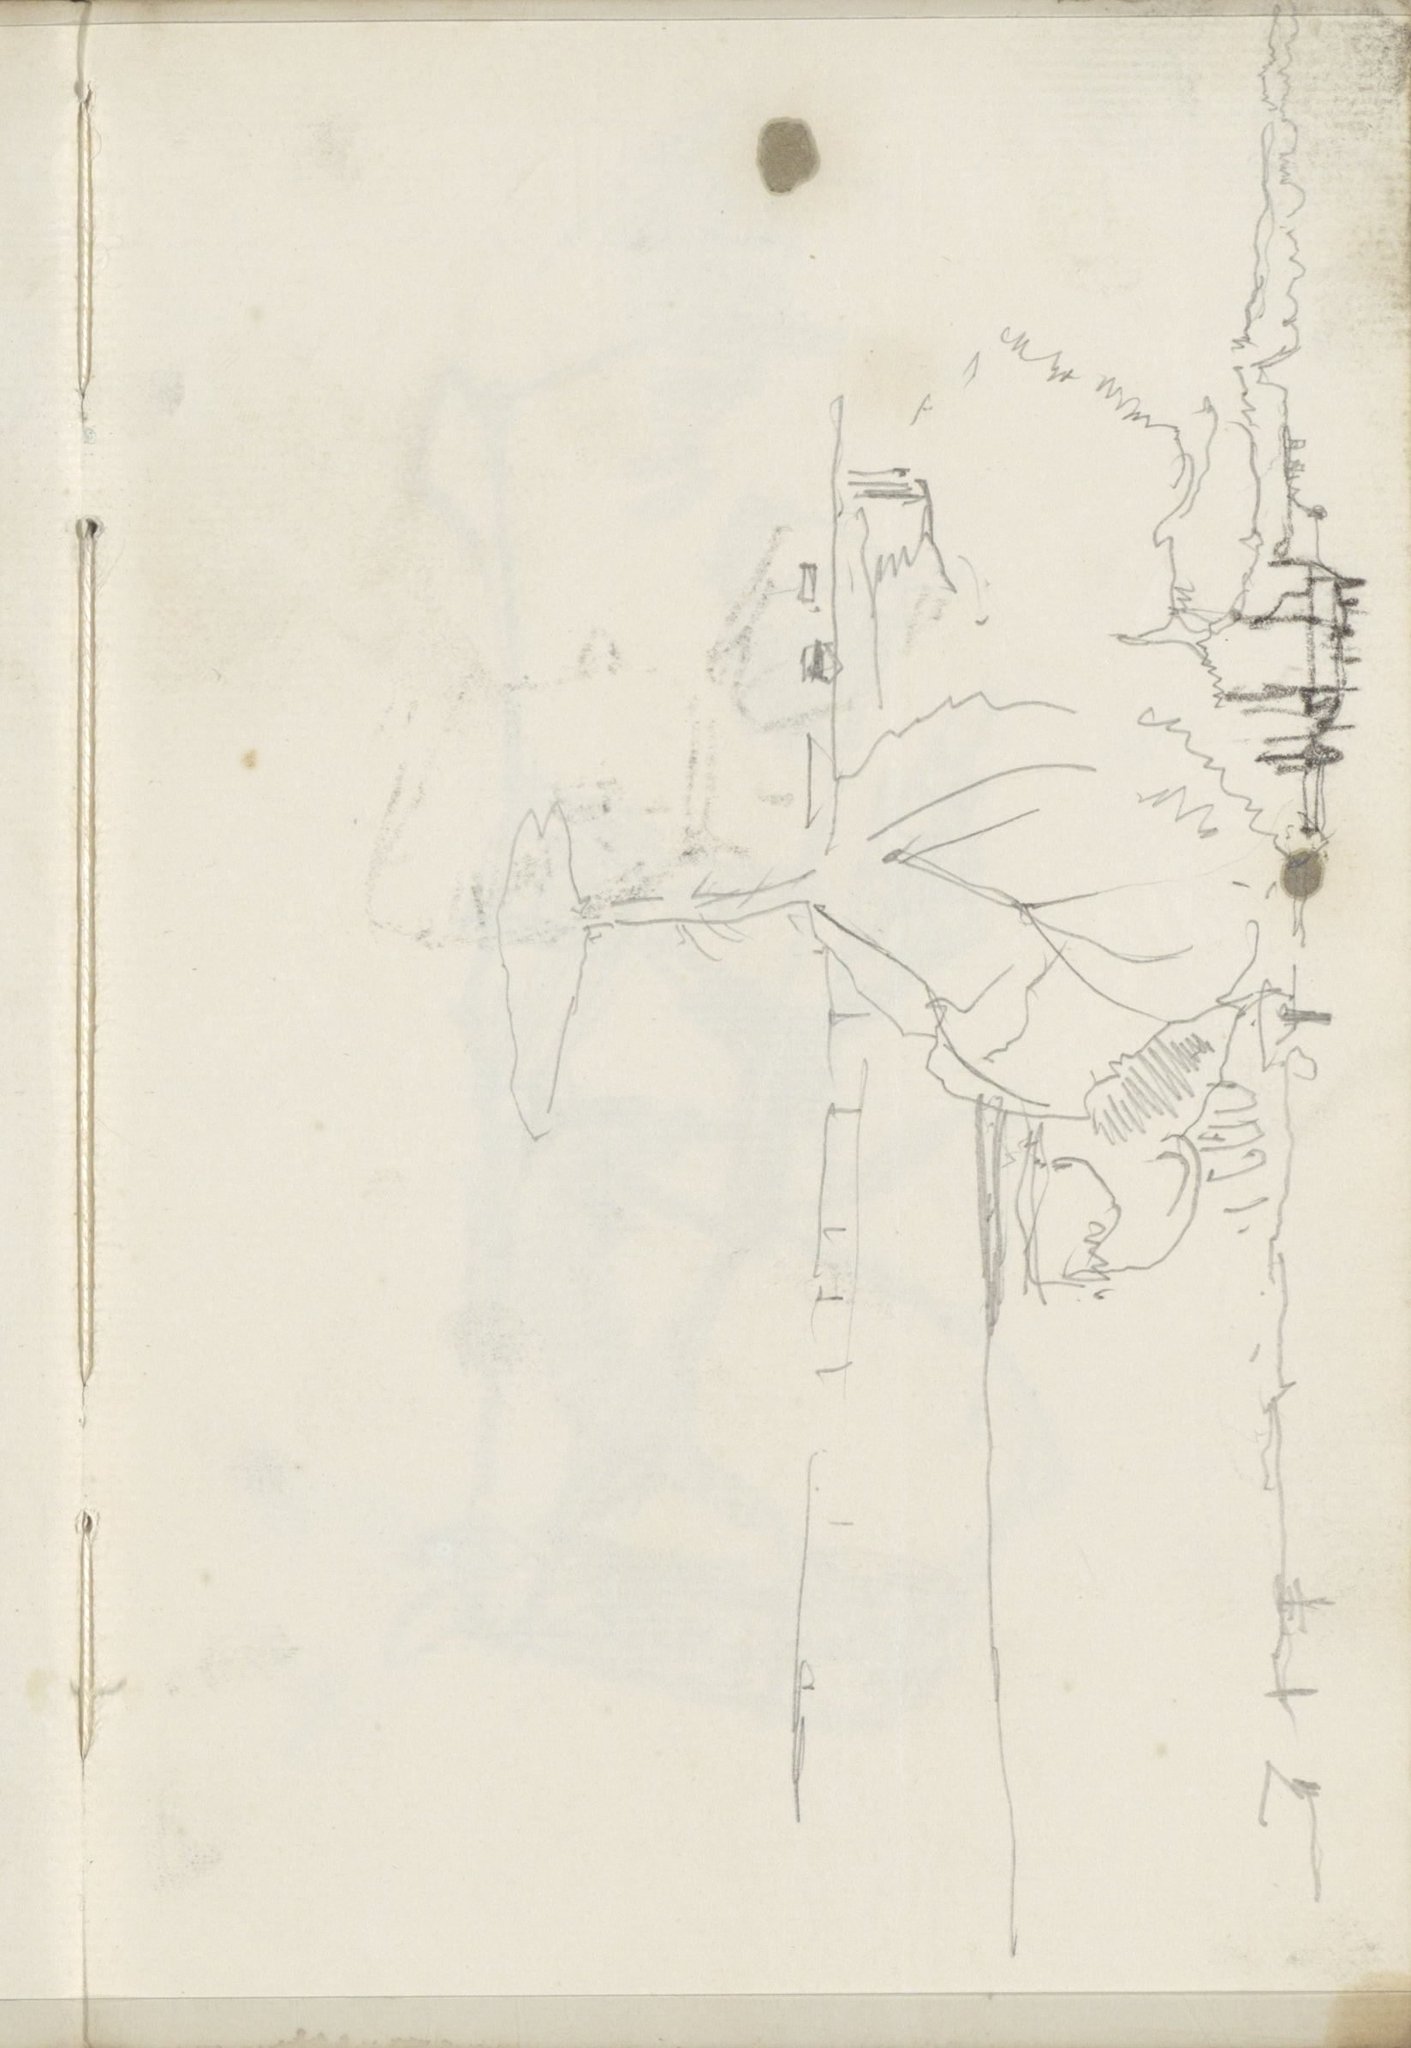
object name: sketchbook leaf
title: Landschap met bebouwing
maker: george hendrik breitner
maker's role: draughtsman, painter, print maker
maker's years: 1857-1923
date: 1886-1898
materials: chalk, paper, pencil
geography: amsterdam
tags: landscapes, civic architecture; edifices; dwellings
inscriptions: kleurnotitie, handgeschreven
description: Pagina 28 uit een schetsboek met 21 bladen.